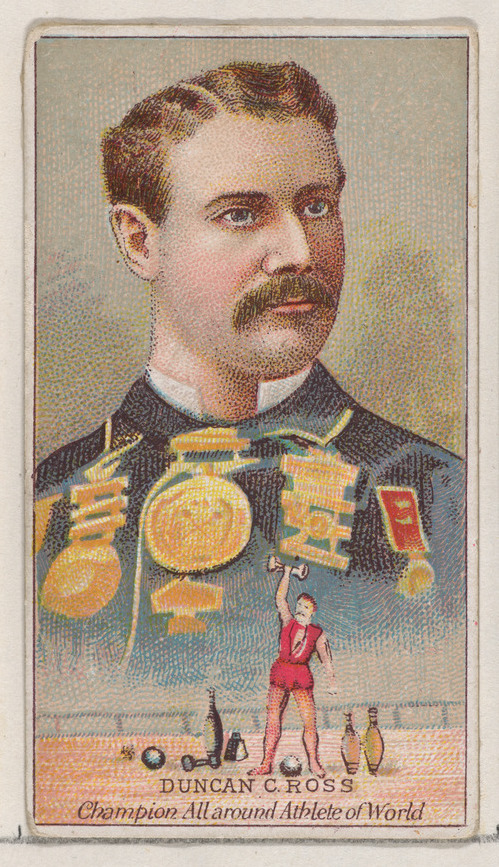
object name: print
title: Duncan C. Ross, Champion All Around Athlete of the World, from the Champions of Games and Sports series (N184, Type 2) issued by W.S. Kimball & Co.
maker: w.s. kimball & co.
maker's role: publisher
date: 1887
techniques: color lithograph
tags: men,athletes